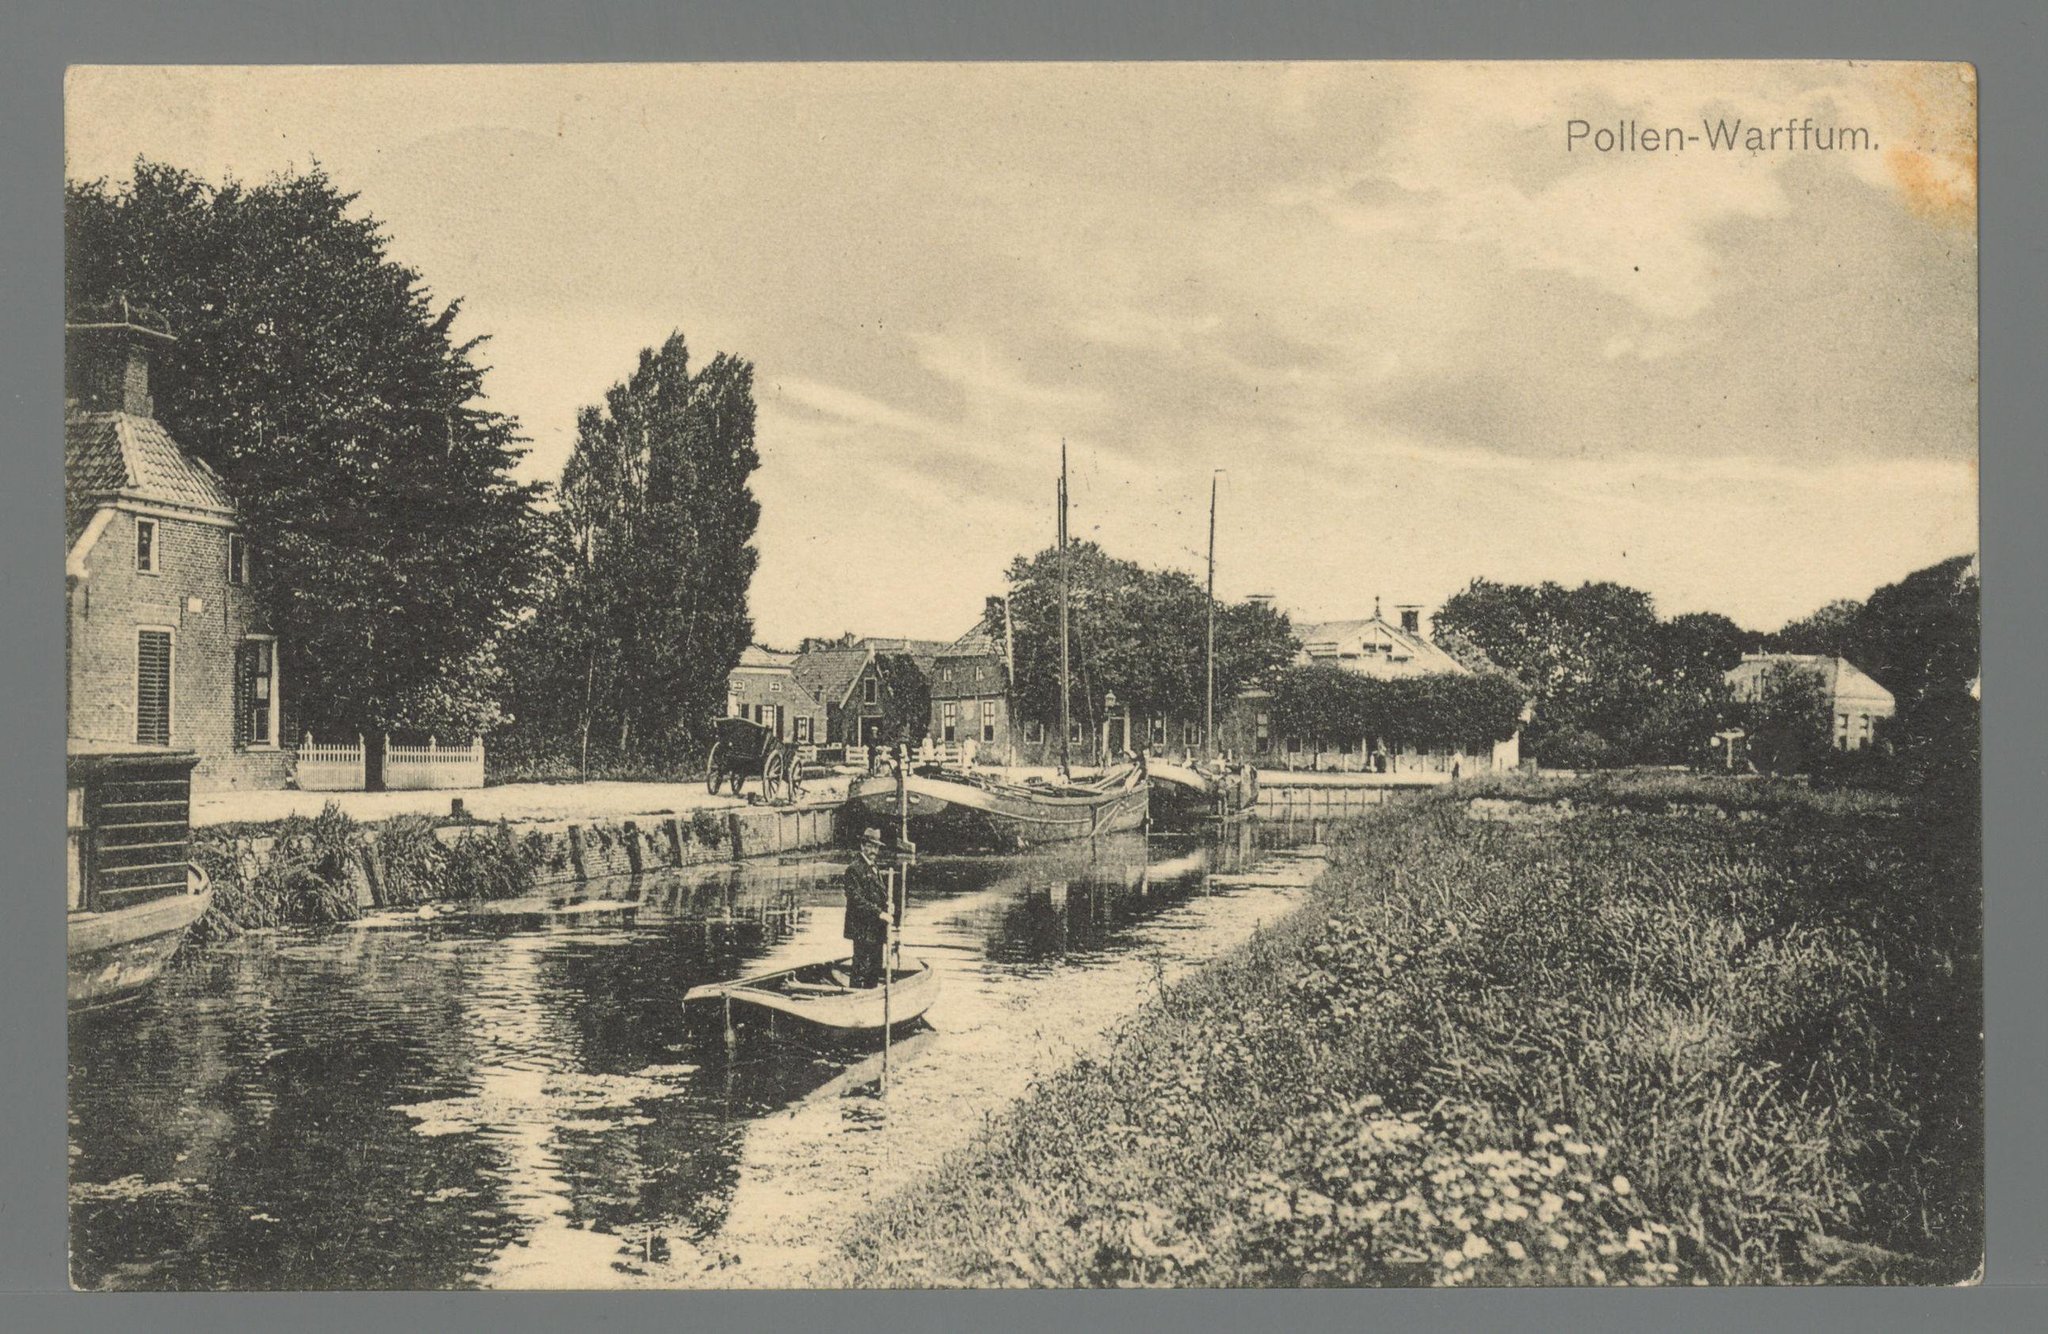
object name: photomechanical print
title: Pollen-Warffum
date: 1905-1913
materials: cardboard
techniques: photograph, writing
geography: warffum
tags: city-view, and landscape with man-made constructions, canal, ships (in general)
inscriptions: postage stamp